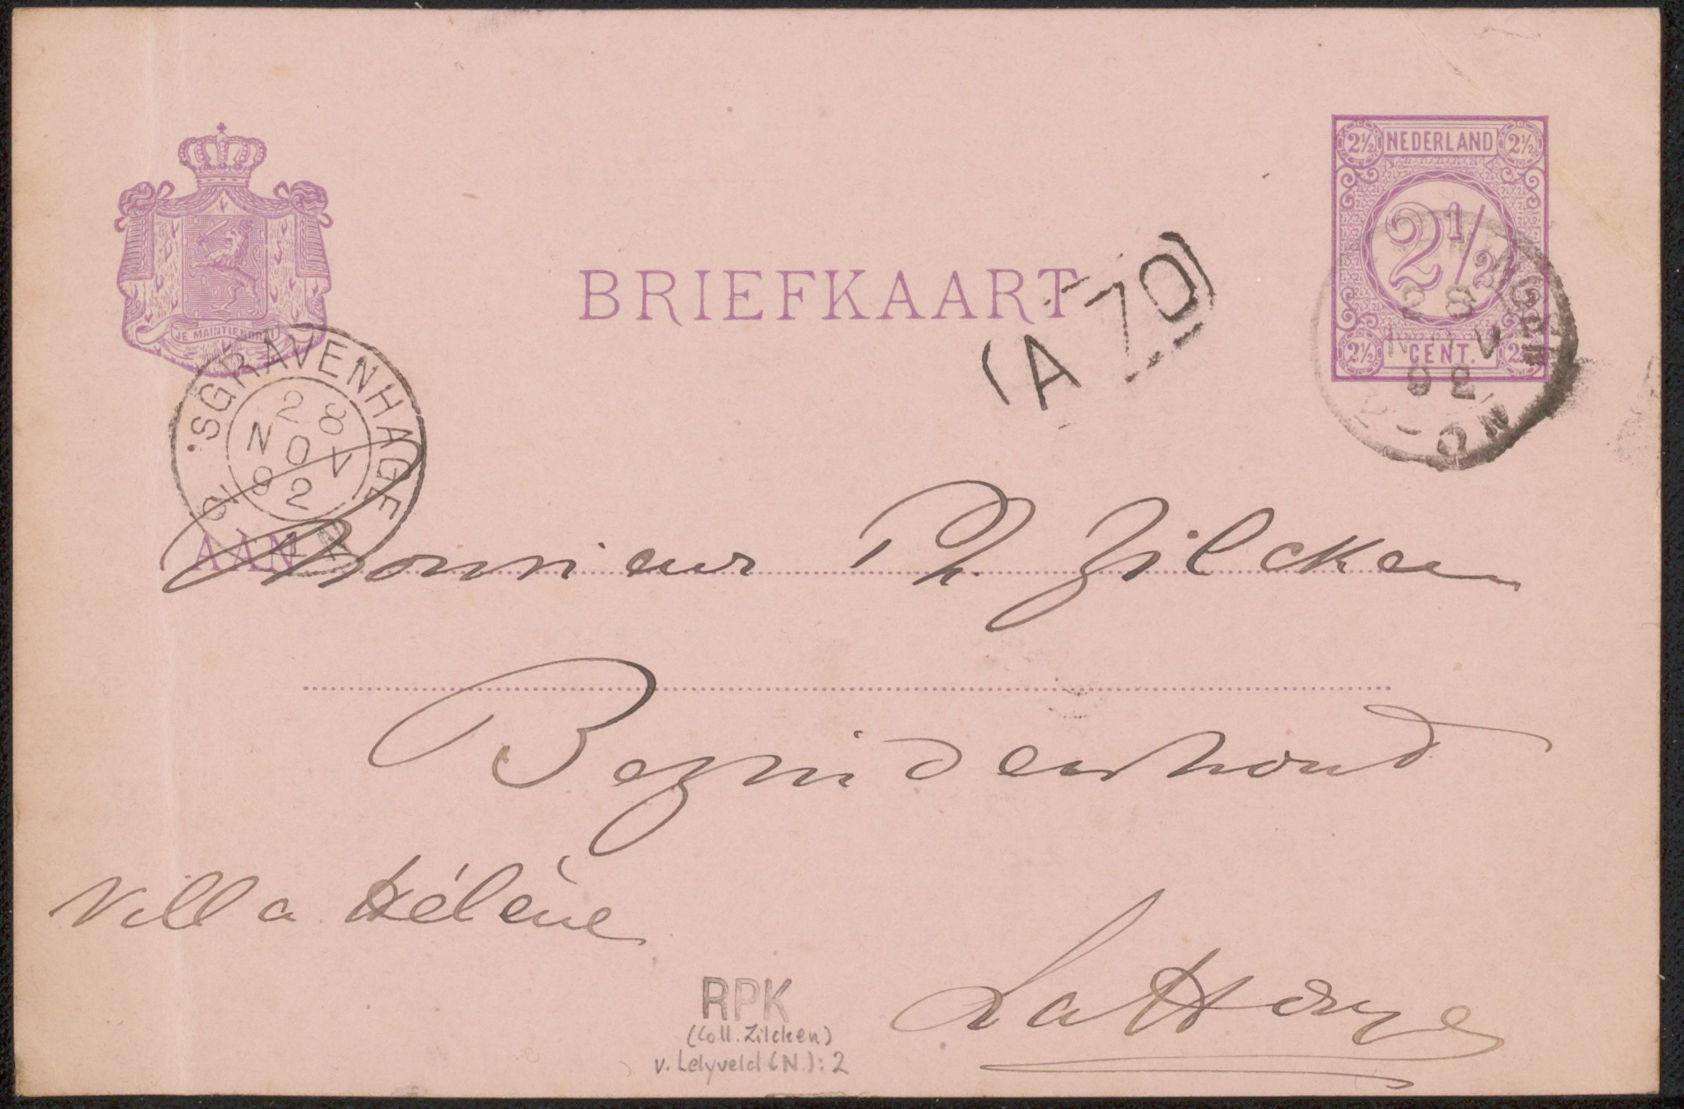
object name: postcard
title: Briefkaart aan Philip Zilcken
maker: nellie van lelyveld-mess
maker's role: sculptor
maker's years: 1869-1904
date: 1892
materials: cardboard, ink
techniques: pen, writing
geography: scheveningen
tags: the hague, painter, draughtsman, philip zilcken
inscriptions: collector's mark: ‘RPK’